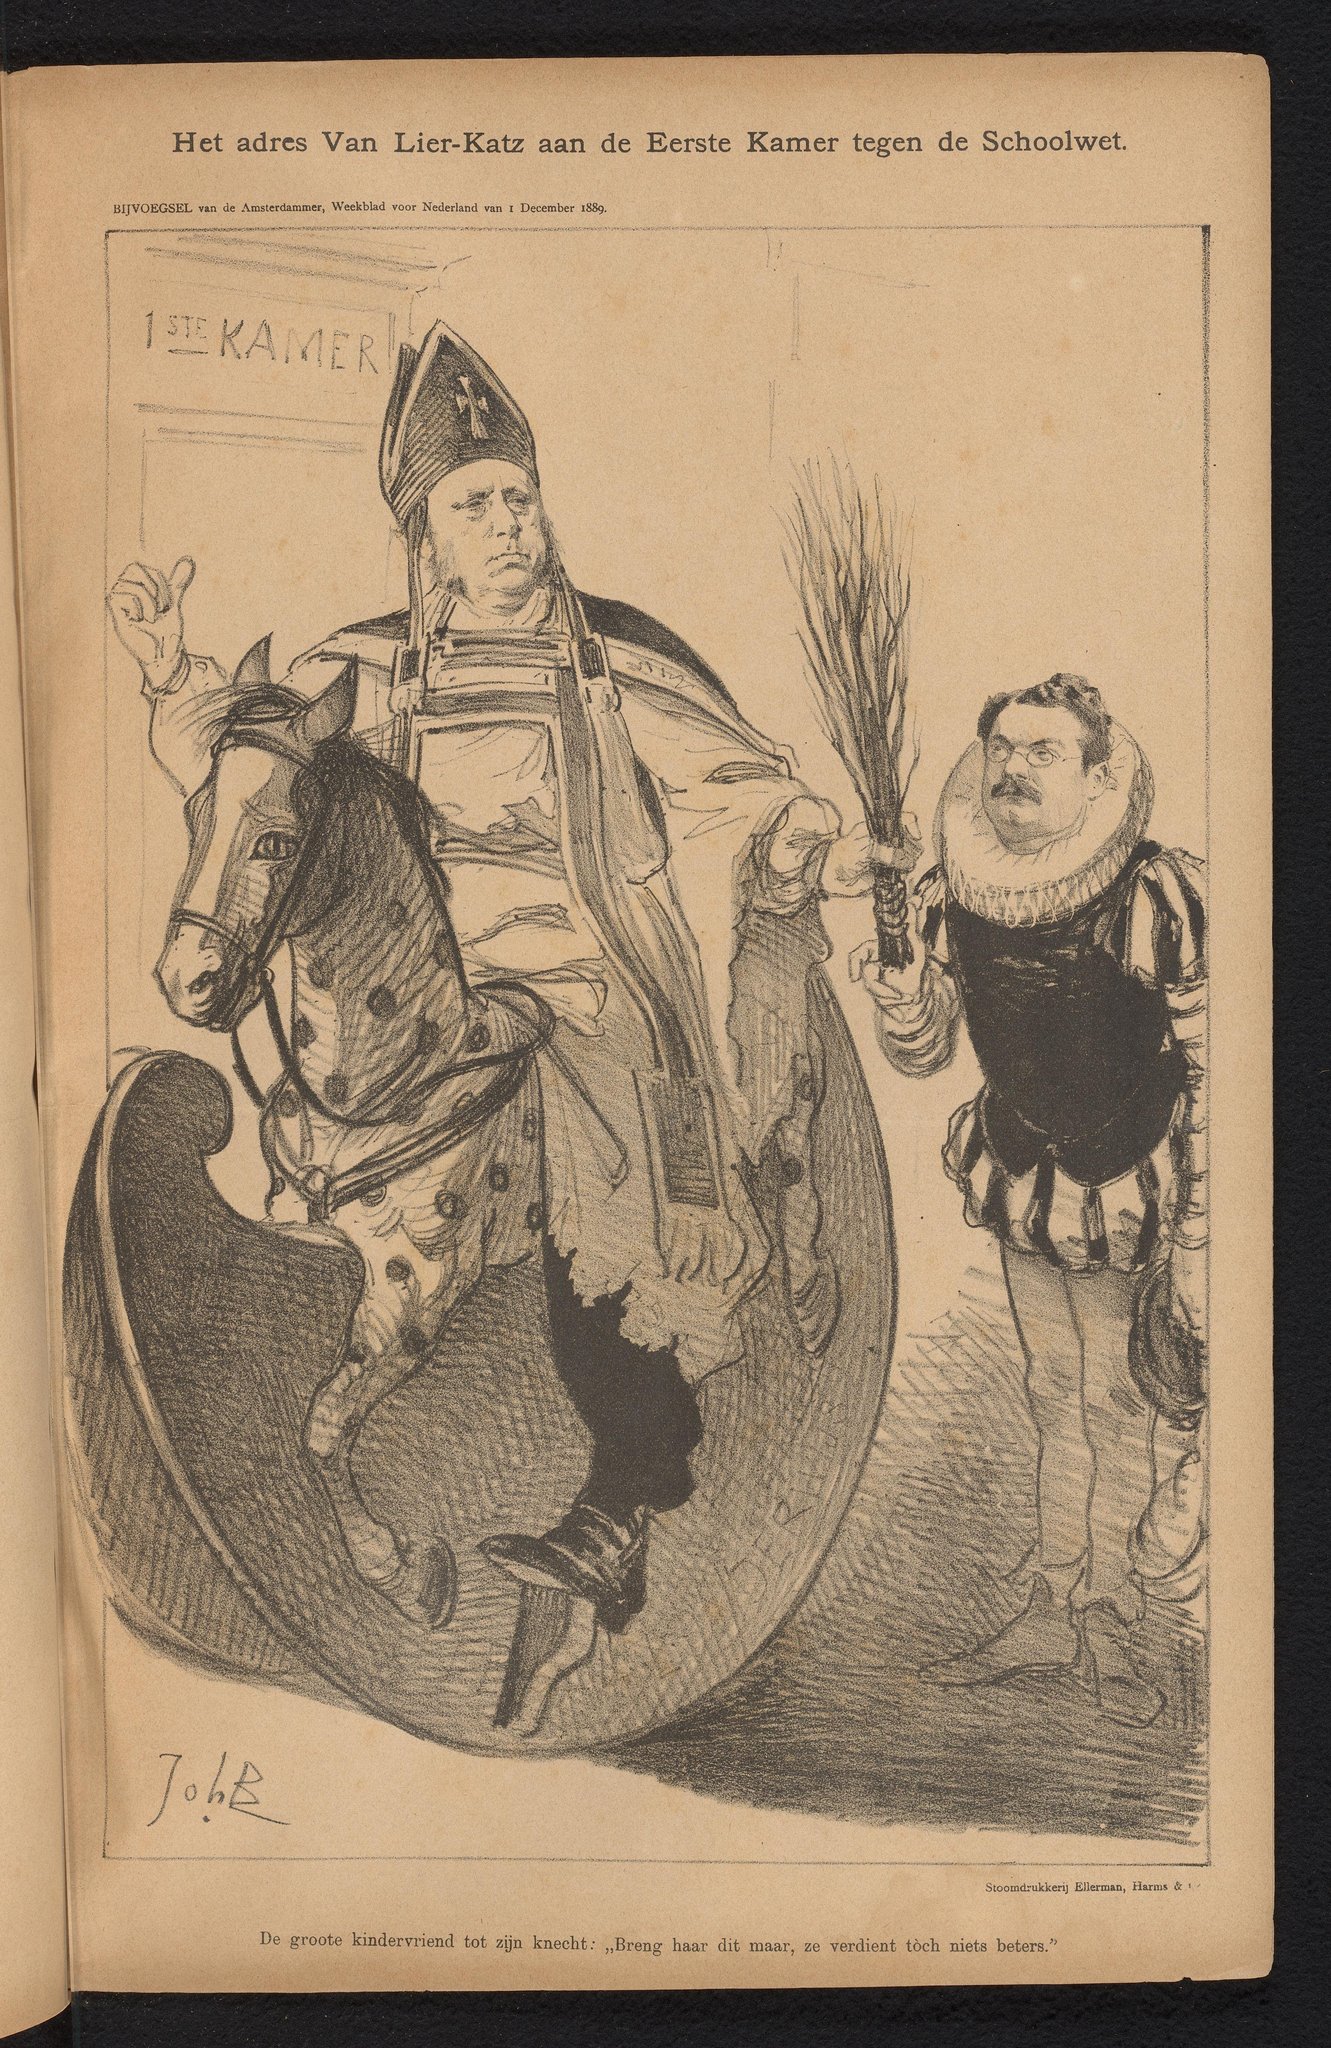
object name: cartoon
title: Het adres Van Lier-Katz aan de Eerste Kamer tegen de Schoolwet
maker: johan braakensiek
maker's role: draughtsman, print maker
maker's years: 1858-1940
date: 1889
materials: paper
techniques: lithograph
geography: amsterdam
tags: amsterdam, festivities on st. nicholas (eve) (december 5), political caricatures and satires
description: Eerste Kamerlid Hendrik van Lier als Sinterklaas op een hobbelpaard. Hij geeft zijn knecht Samuël Katz de opdracht een roe te geven aan de Eerste Kamer in het kader van de Schoolstrijd.